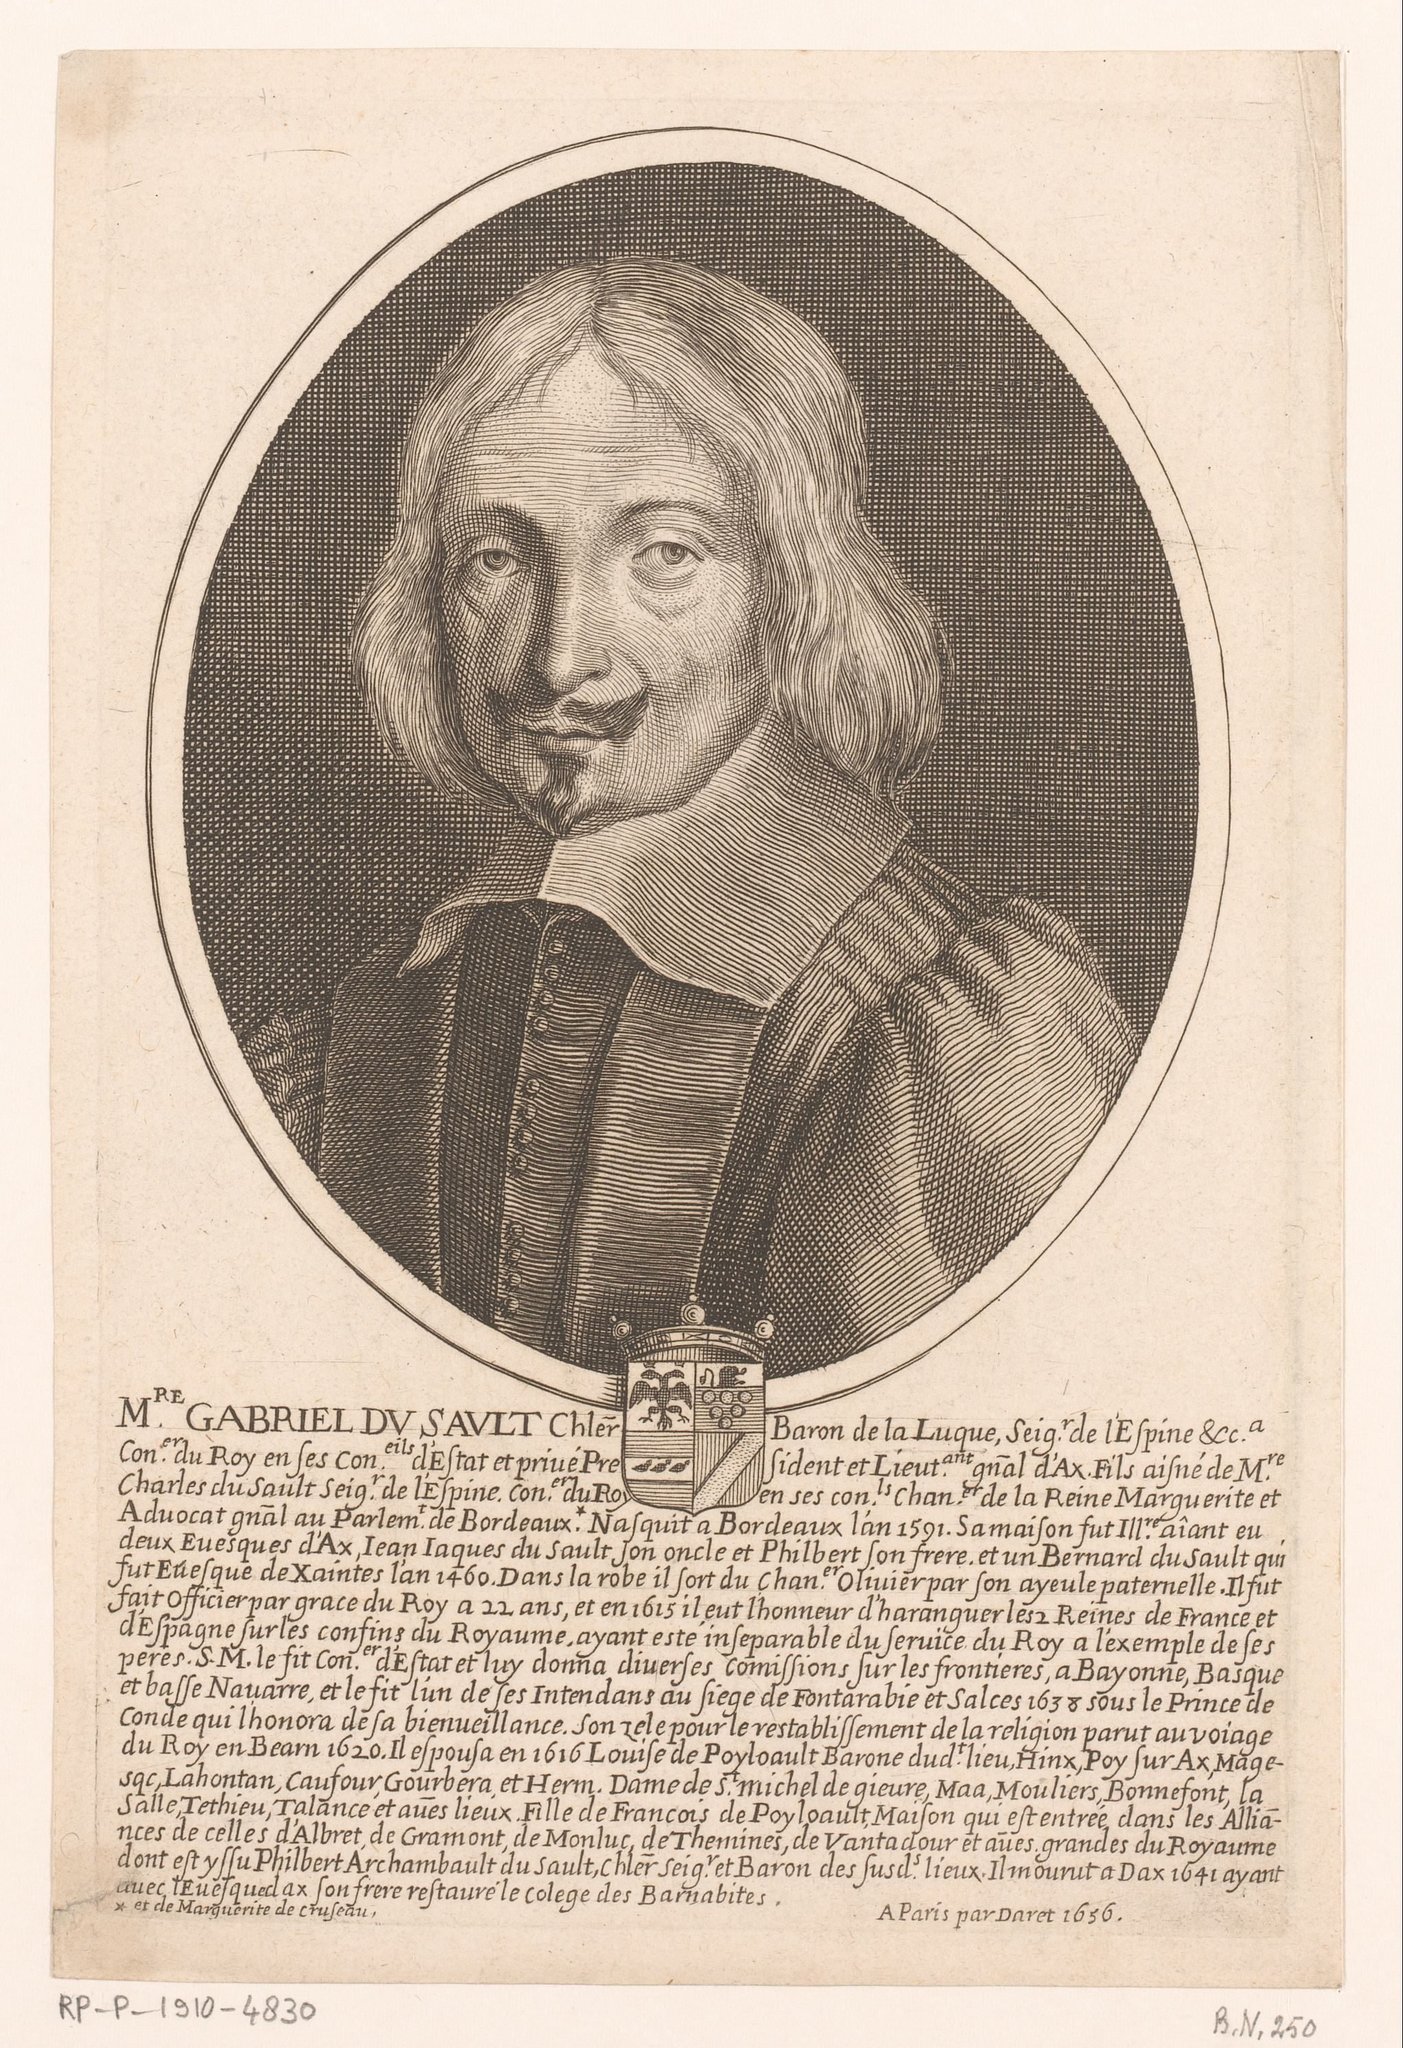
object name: print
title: Tableaux historiques ou sont gravez les Illustres François et Etrangiers de l'un et l'autre sexe (...)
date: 1656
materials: paper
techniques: engraving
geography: paris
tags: historical persons, armorial bearing, heraldry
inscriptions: collector's mark: Lugt 2228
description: Maakt deel uit van een serie portretten getiteld 'Tableaux historiques ou sont gravez les Illustres François et Etrangiers de l'un et l'autre sexe (...)', voor het eerst uitgegeven in 1652 door Daret. Een tweede staat werd uitgegeven door Boissevin en een derde door Jollain.